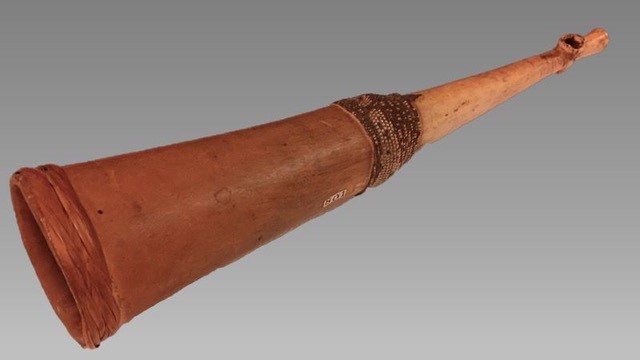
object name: trumpet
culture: melanesian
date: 1867-1900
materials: ivory, rattan, wood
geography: new caledonia